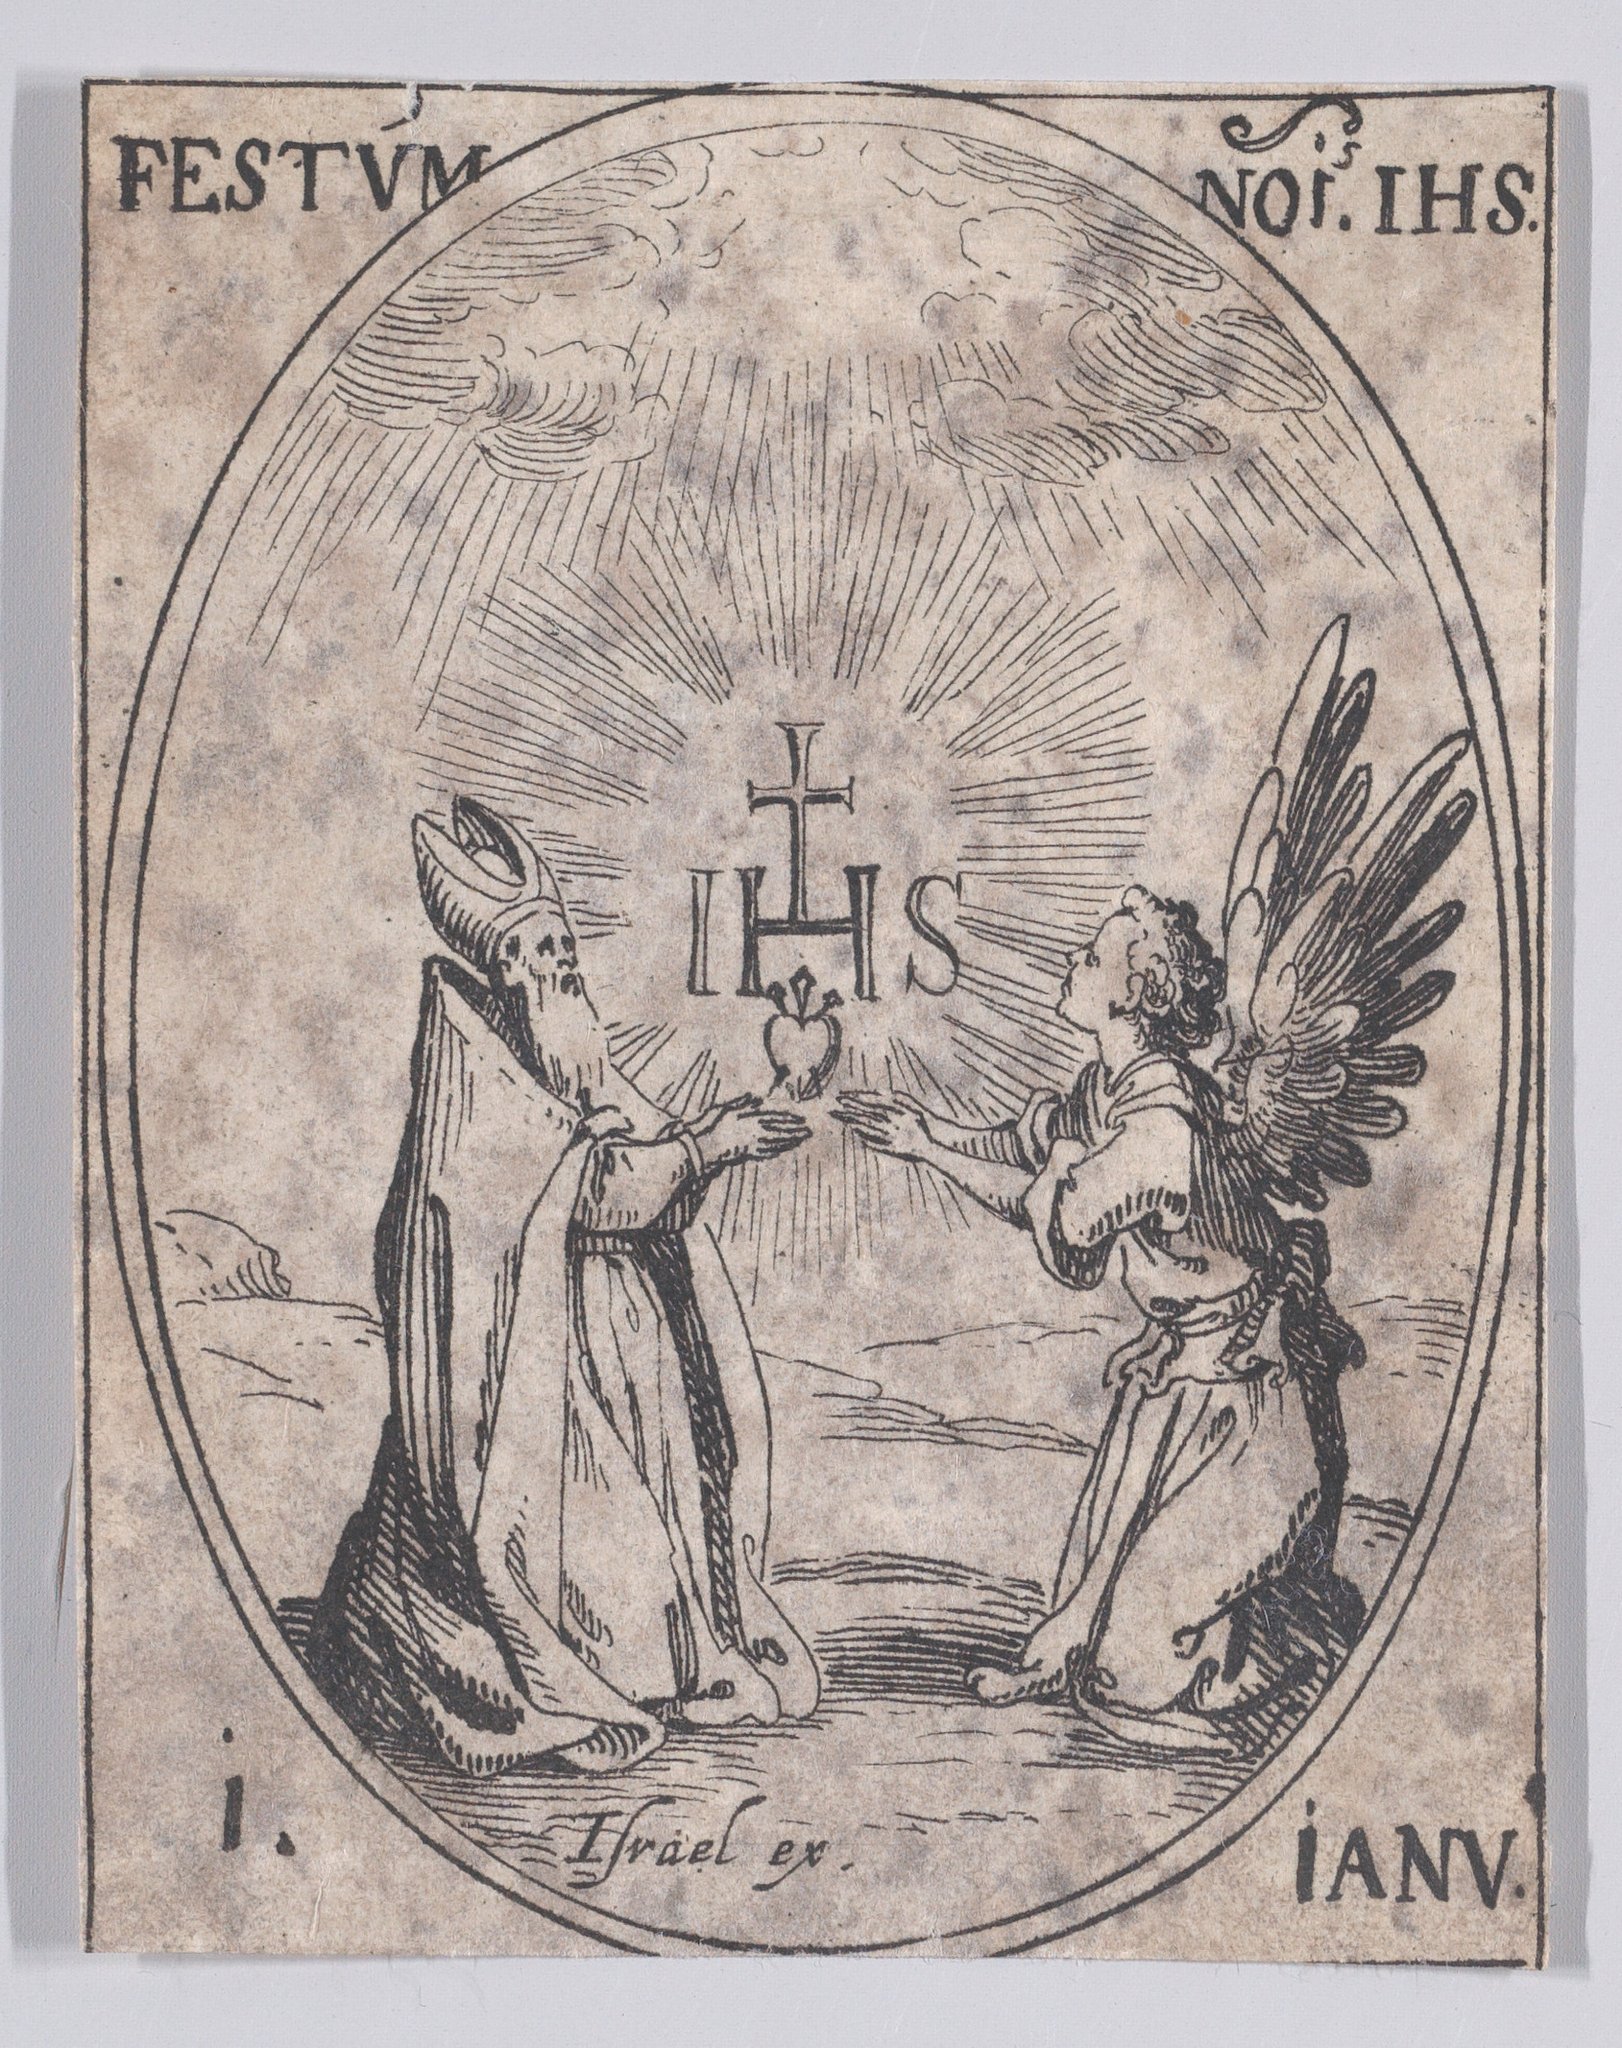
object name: print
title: La Fête du Nom de Jésus (The Feast of the Name of Jesus), January 1st, from "Les Images De Tous Les Saincts et Saintes de L'Année" (Images of All of the Saints and Feast Days of the Year)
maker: jacques callot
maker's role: artist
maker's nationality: french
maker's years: 1592-1635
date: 1636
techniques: etching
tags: men,angels